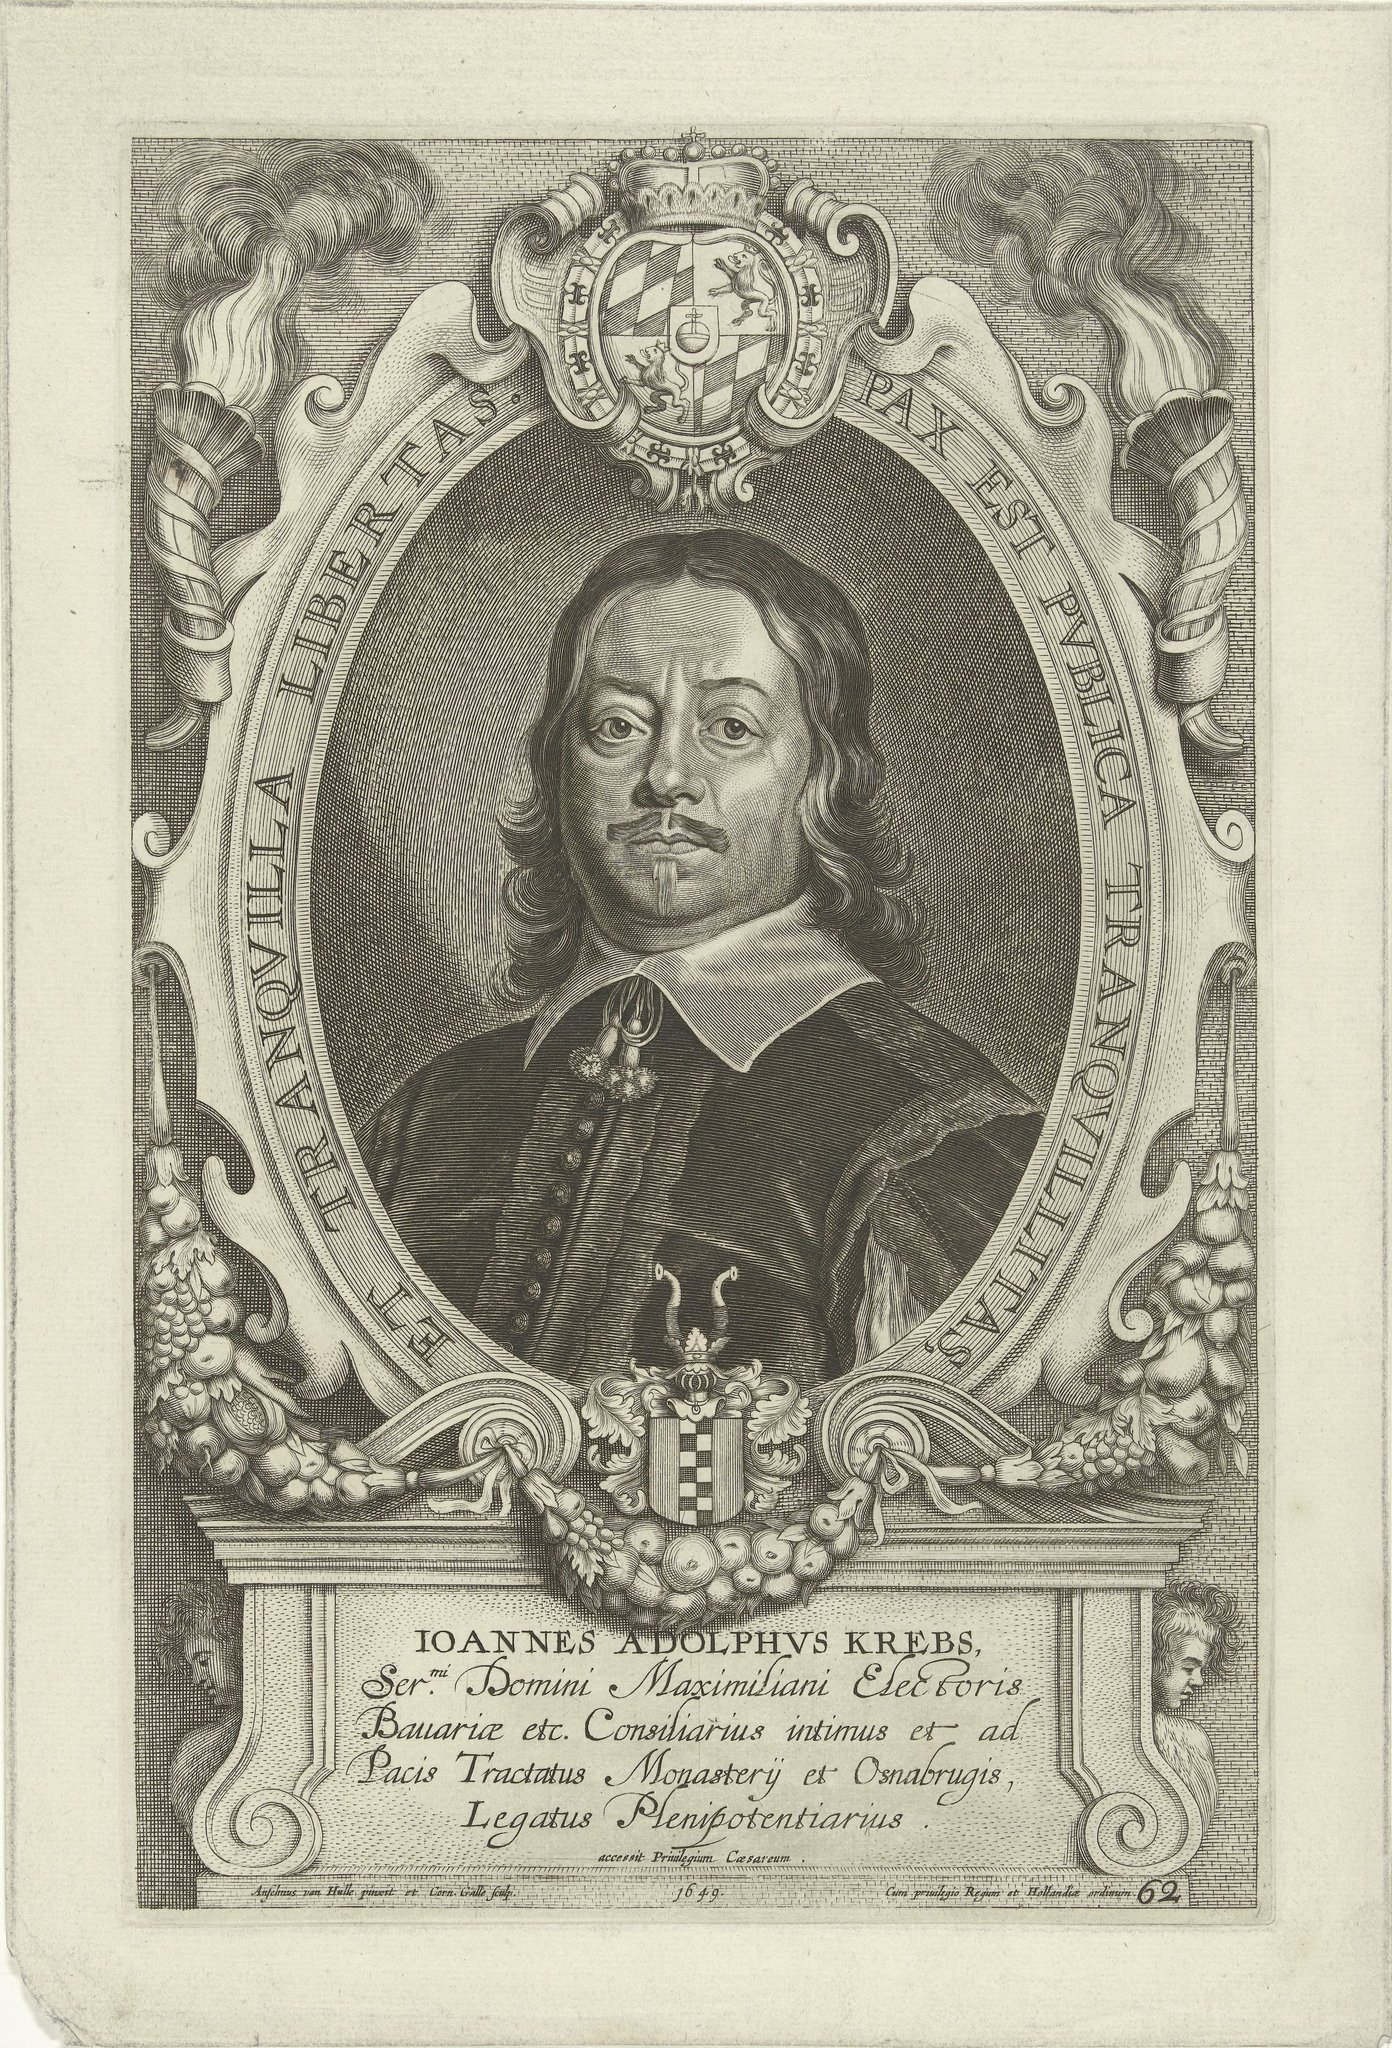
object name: print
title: Portret van Johann Adolf Krebs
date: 1649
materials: paper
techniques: engraving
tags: afgezant, johann adolf krebs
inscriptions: collector's mark: Lugt 2228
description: Portret van Johann Adolf Krebs, afgezant bij de onderhandelingen voor de Vrede van Münster, in ovaal met randschrift in sierlijst.